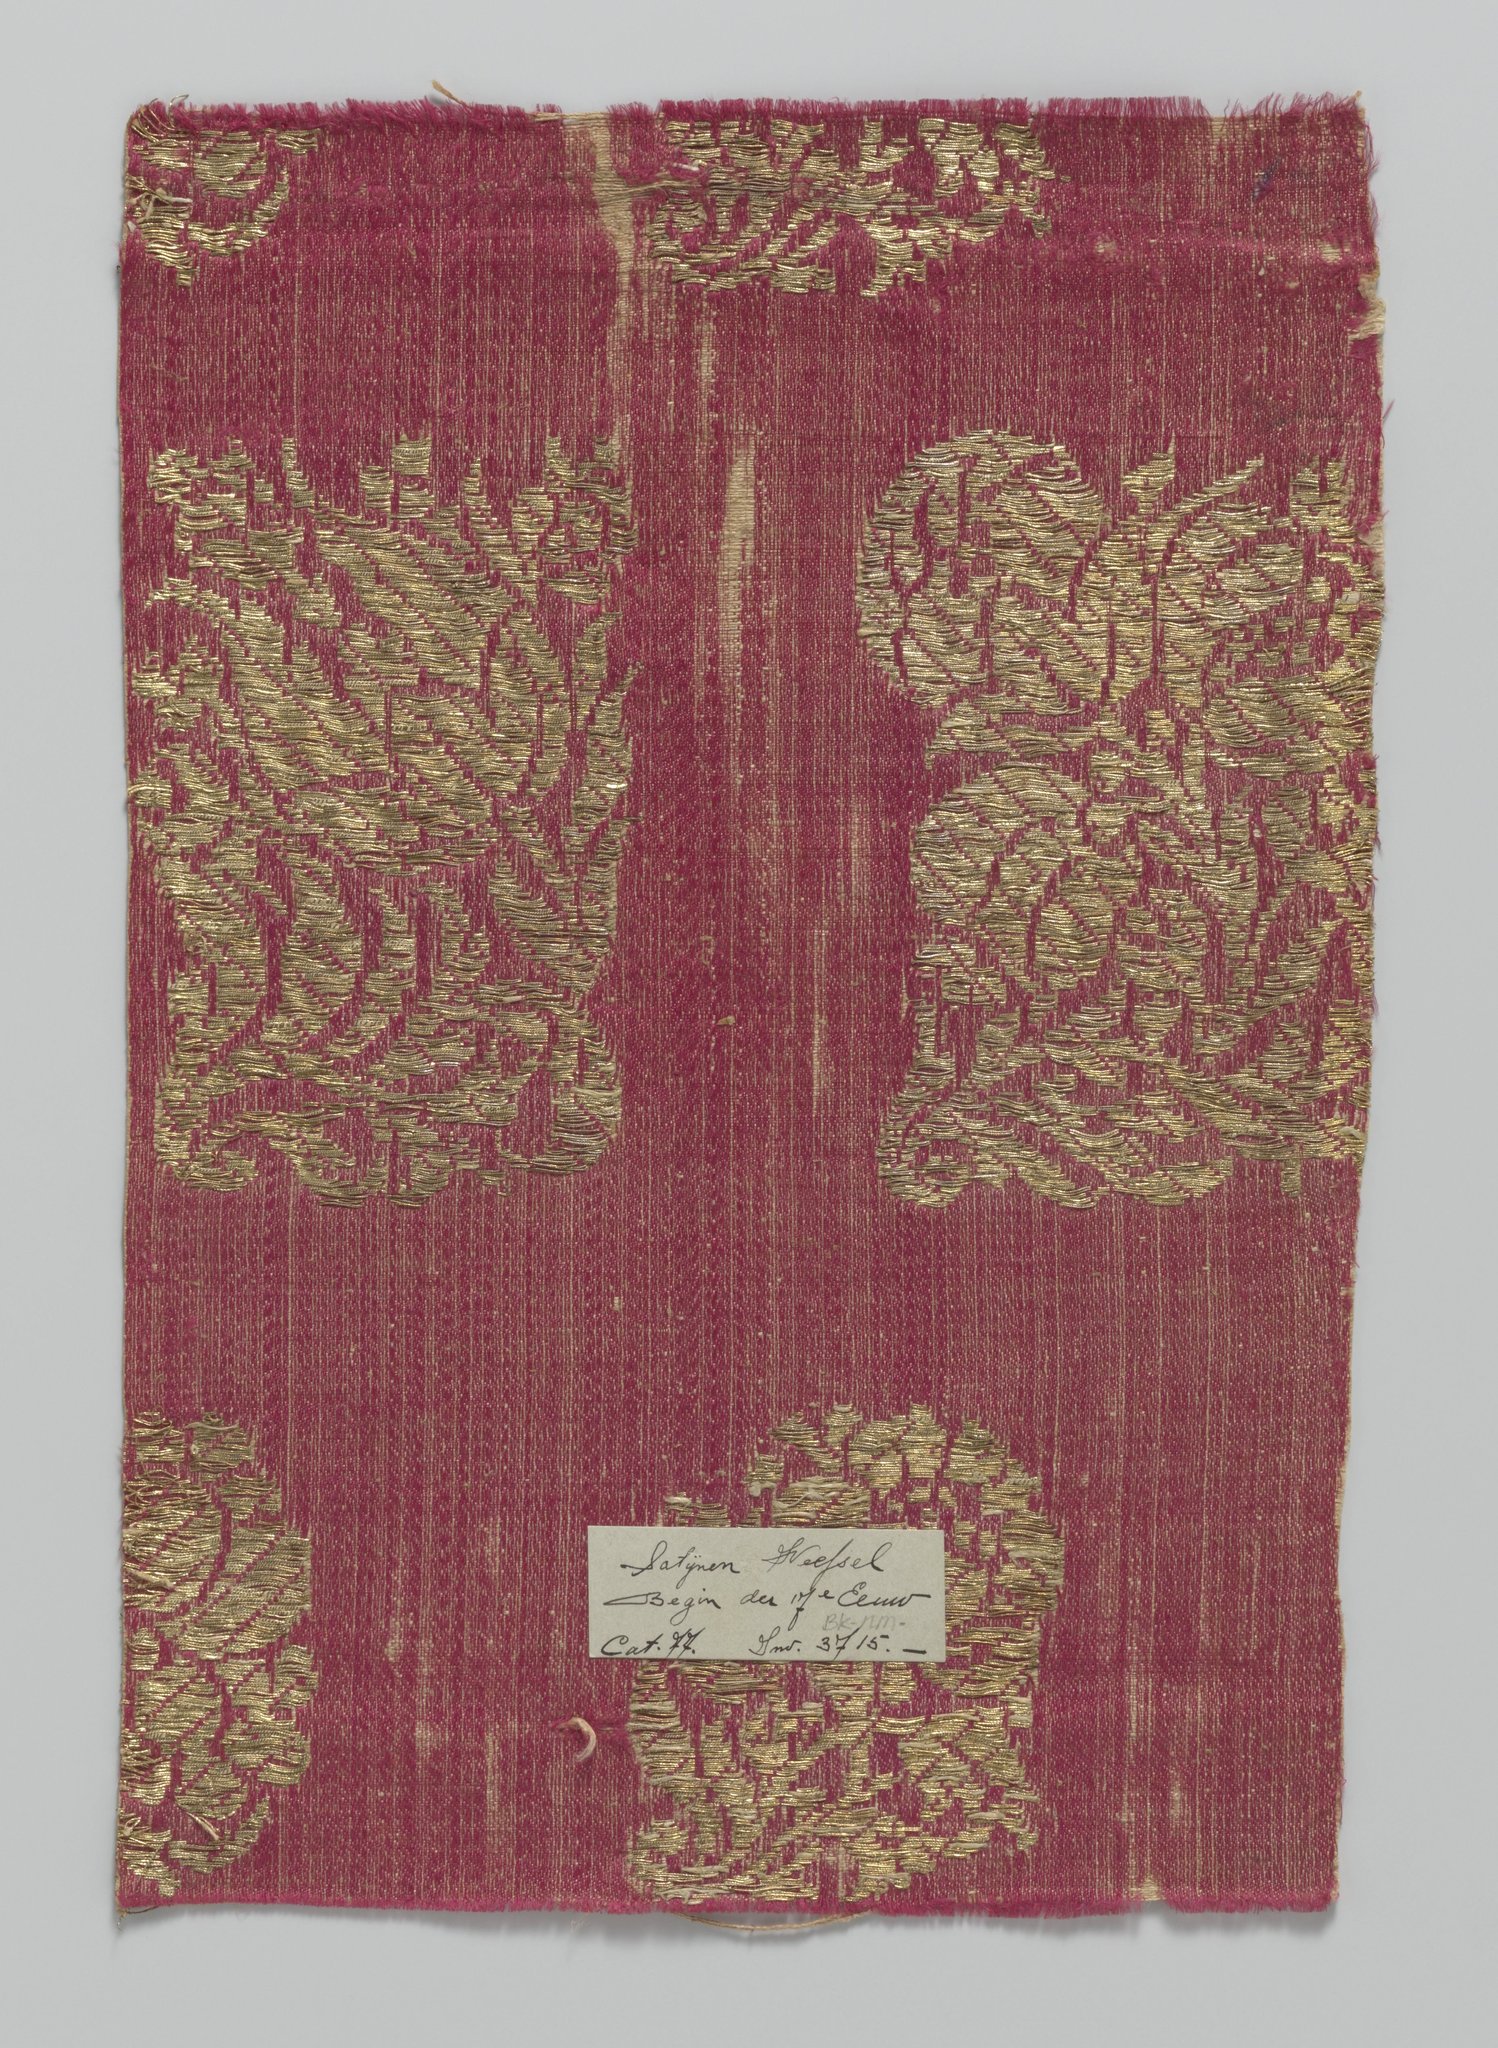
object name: fragment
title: Fragment van wijnrood satijnen weefsel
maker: Anonymous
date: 1600-1625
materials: linen, silk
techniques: brocade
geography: france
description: Wijnrood satijnen weefsel (zijden schering met linnen inslag), doorschoten met goud dat een patroon vormt van rechthoekige figuren, samengesteld uit een tulpvormige bloem en bladeren.